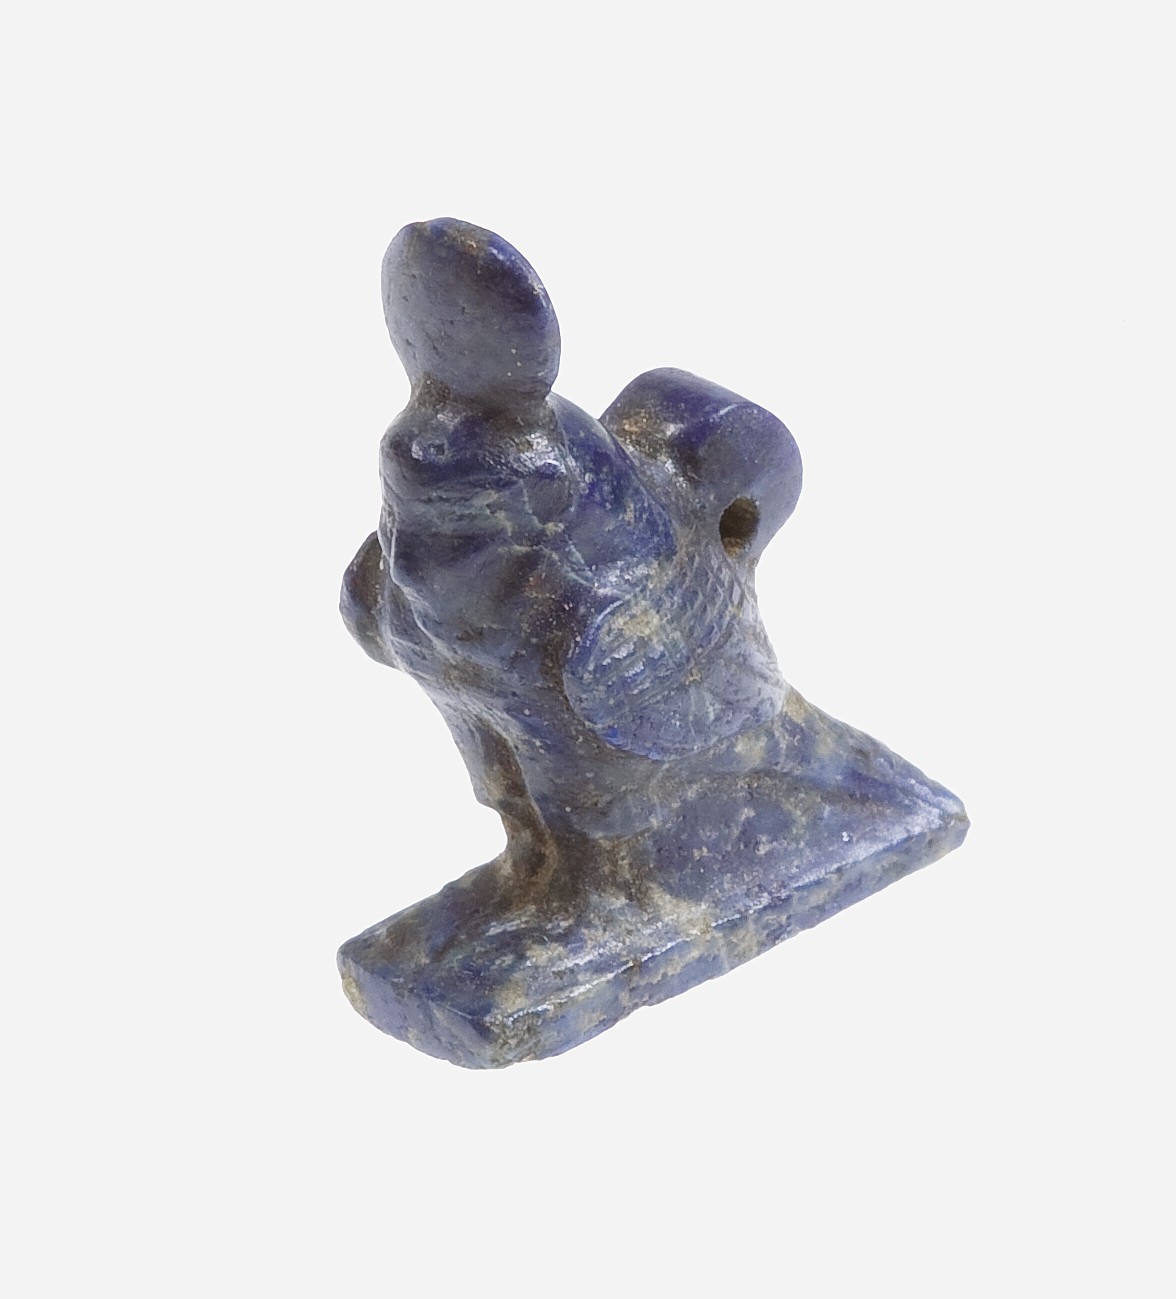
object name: amulet, ba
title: Ba amulet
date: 664-332 BCE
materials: lapis lazuli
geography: egypt